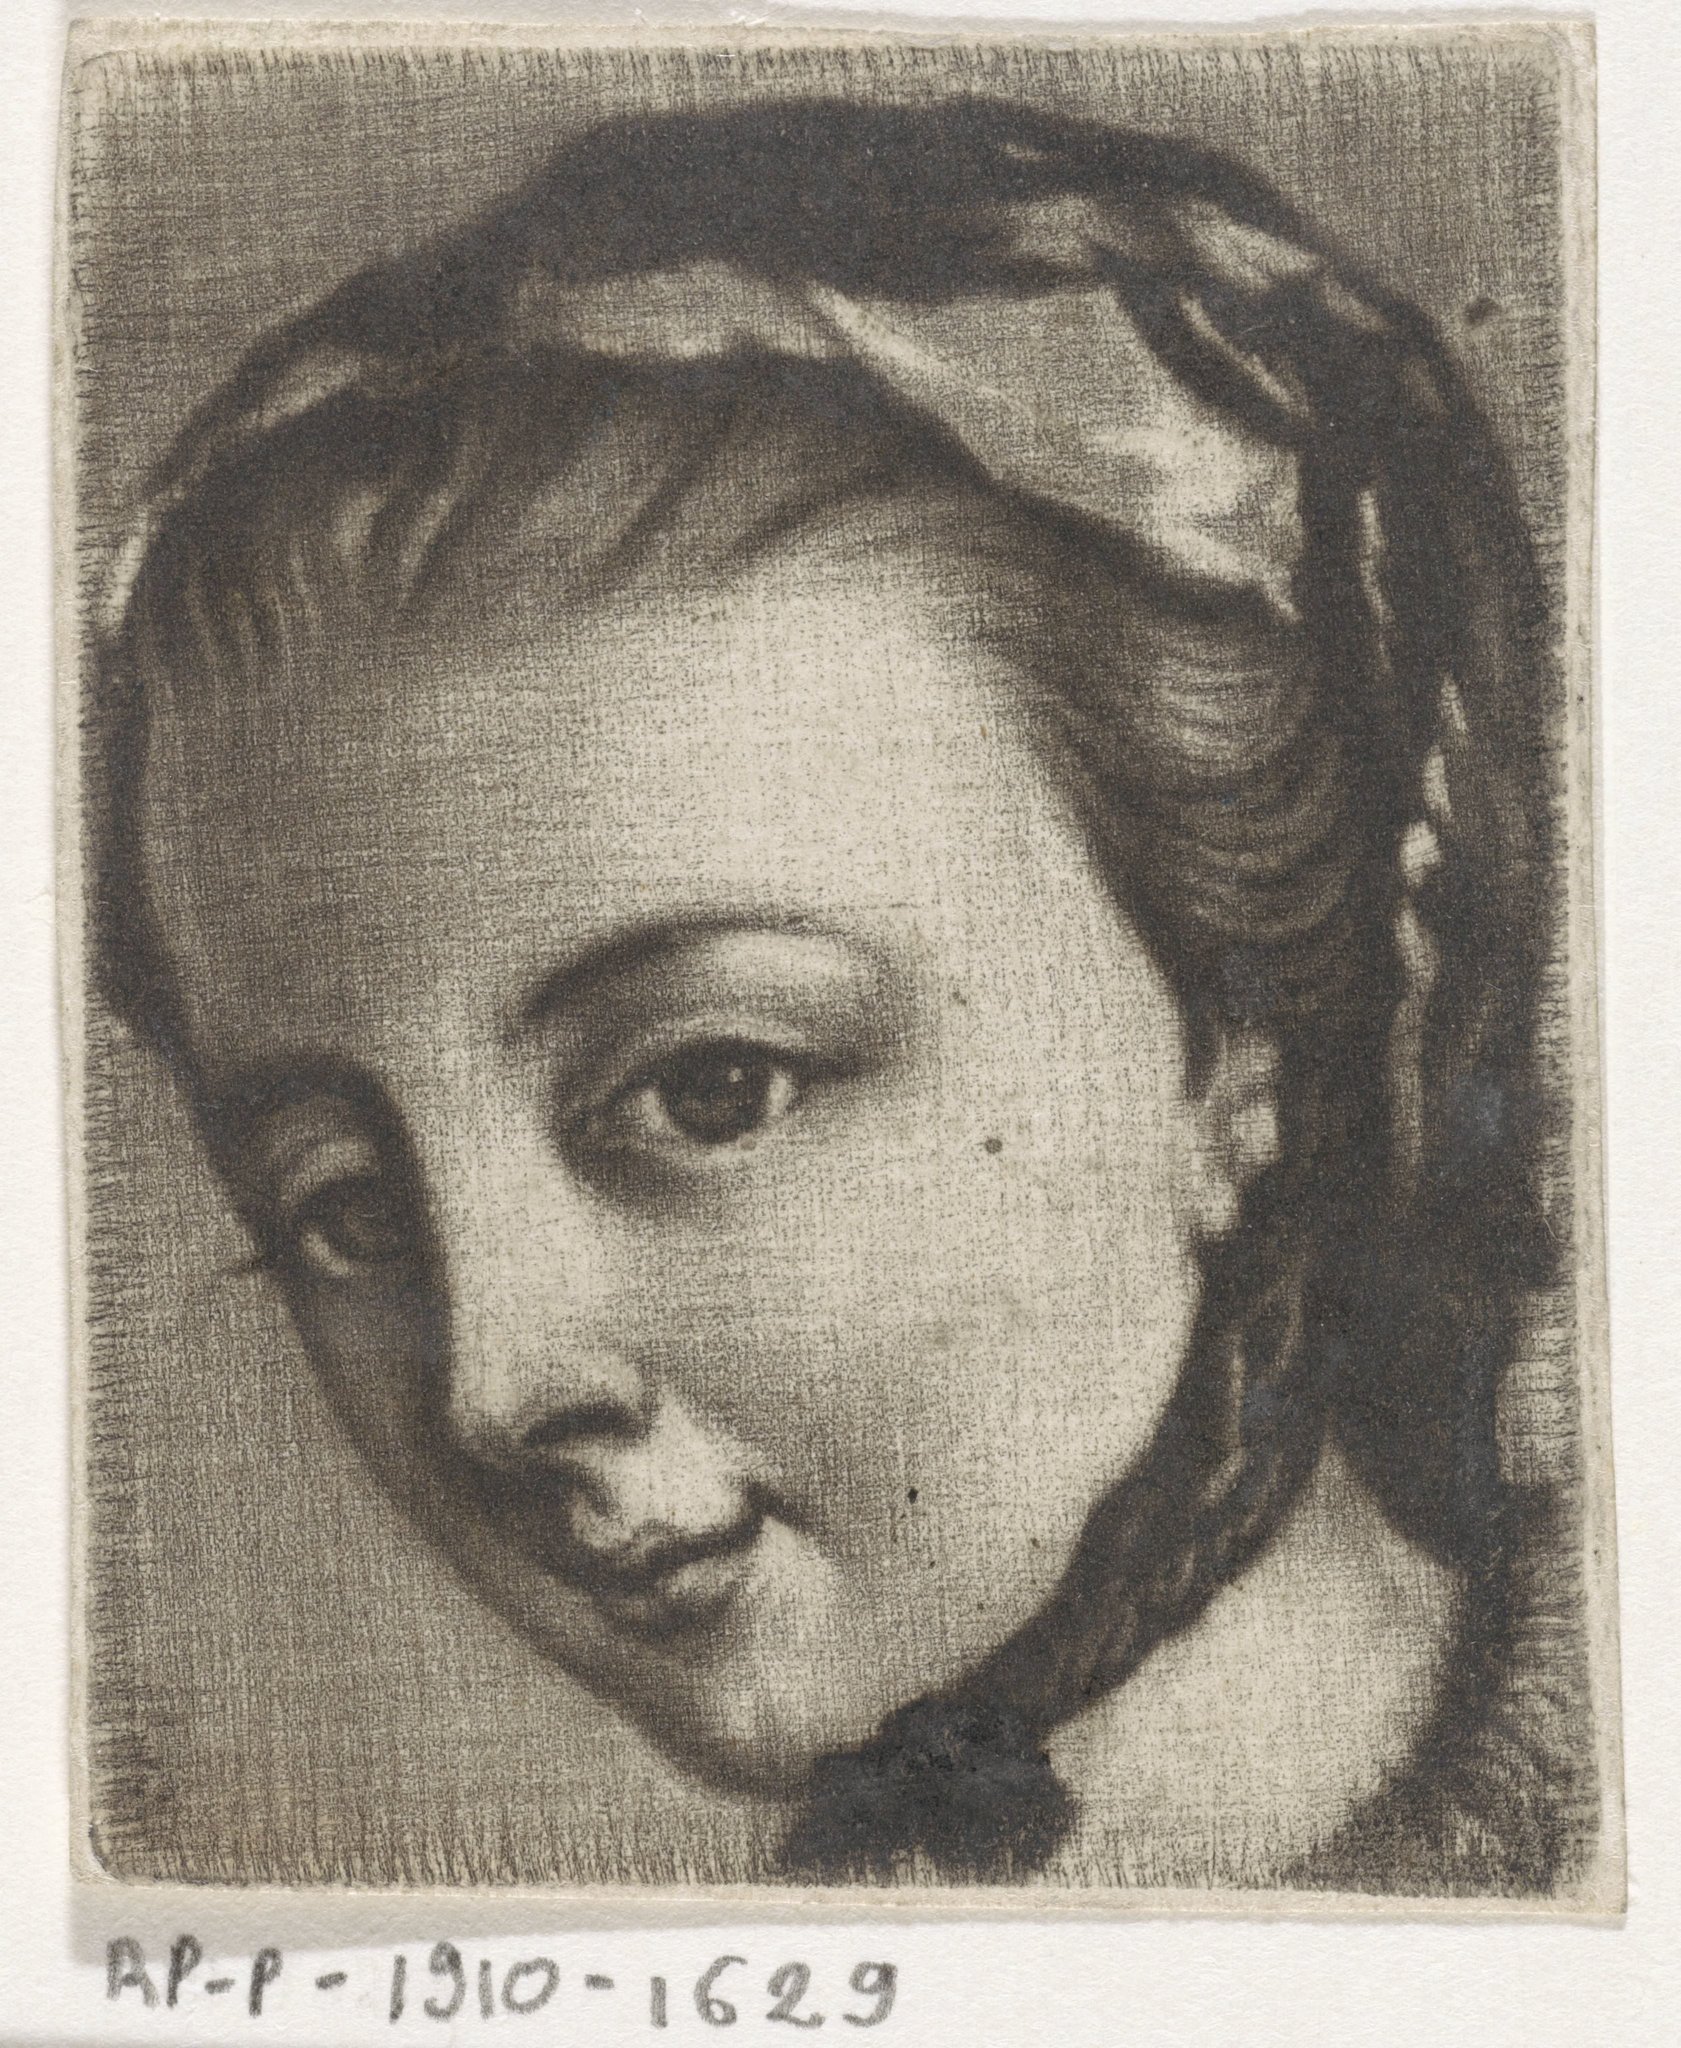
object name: print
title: Kop van een meisje met een kap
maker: Anonymous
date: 1650-1800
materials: paper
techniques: mezzotint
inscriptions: collector's mark: Lugt 2228